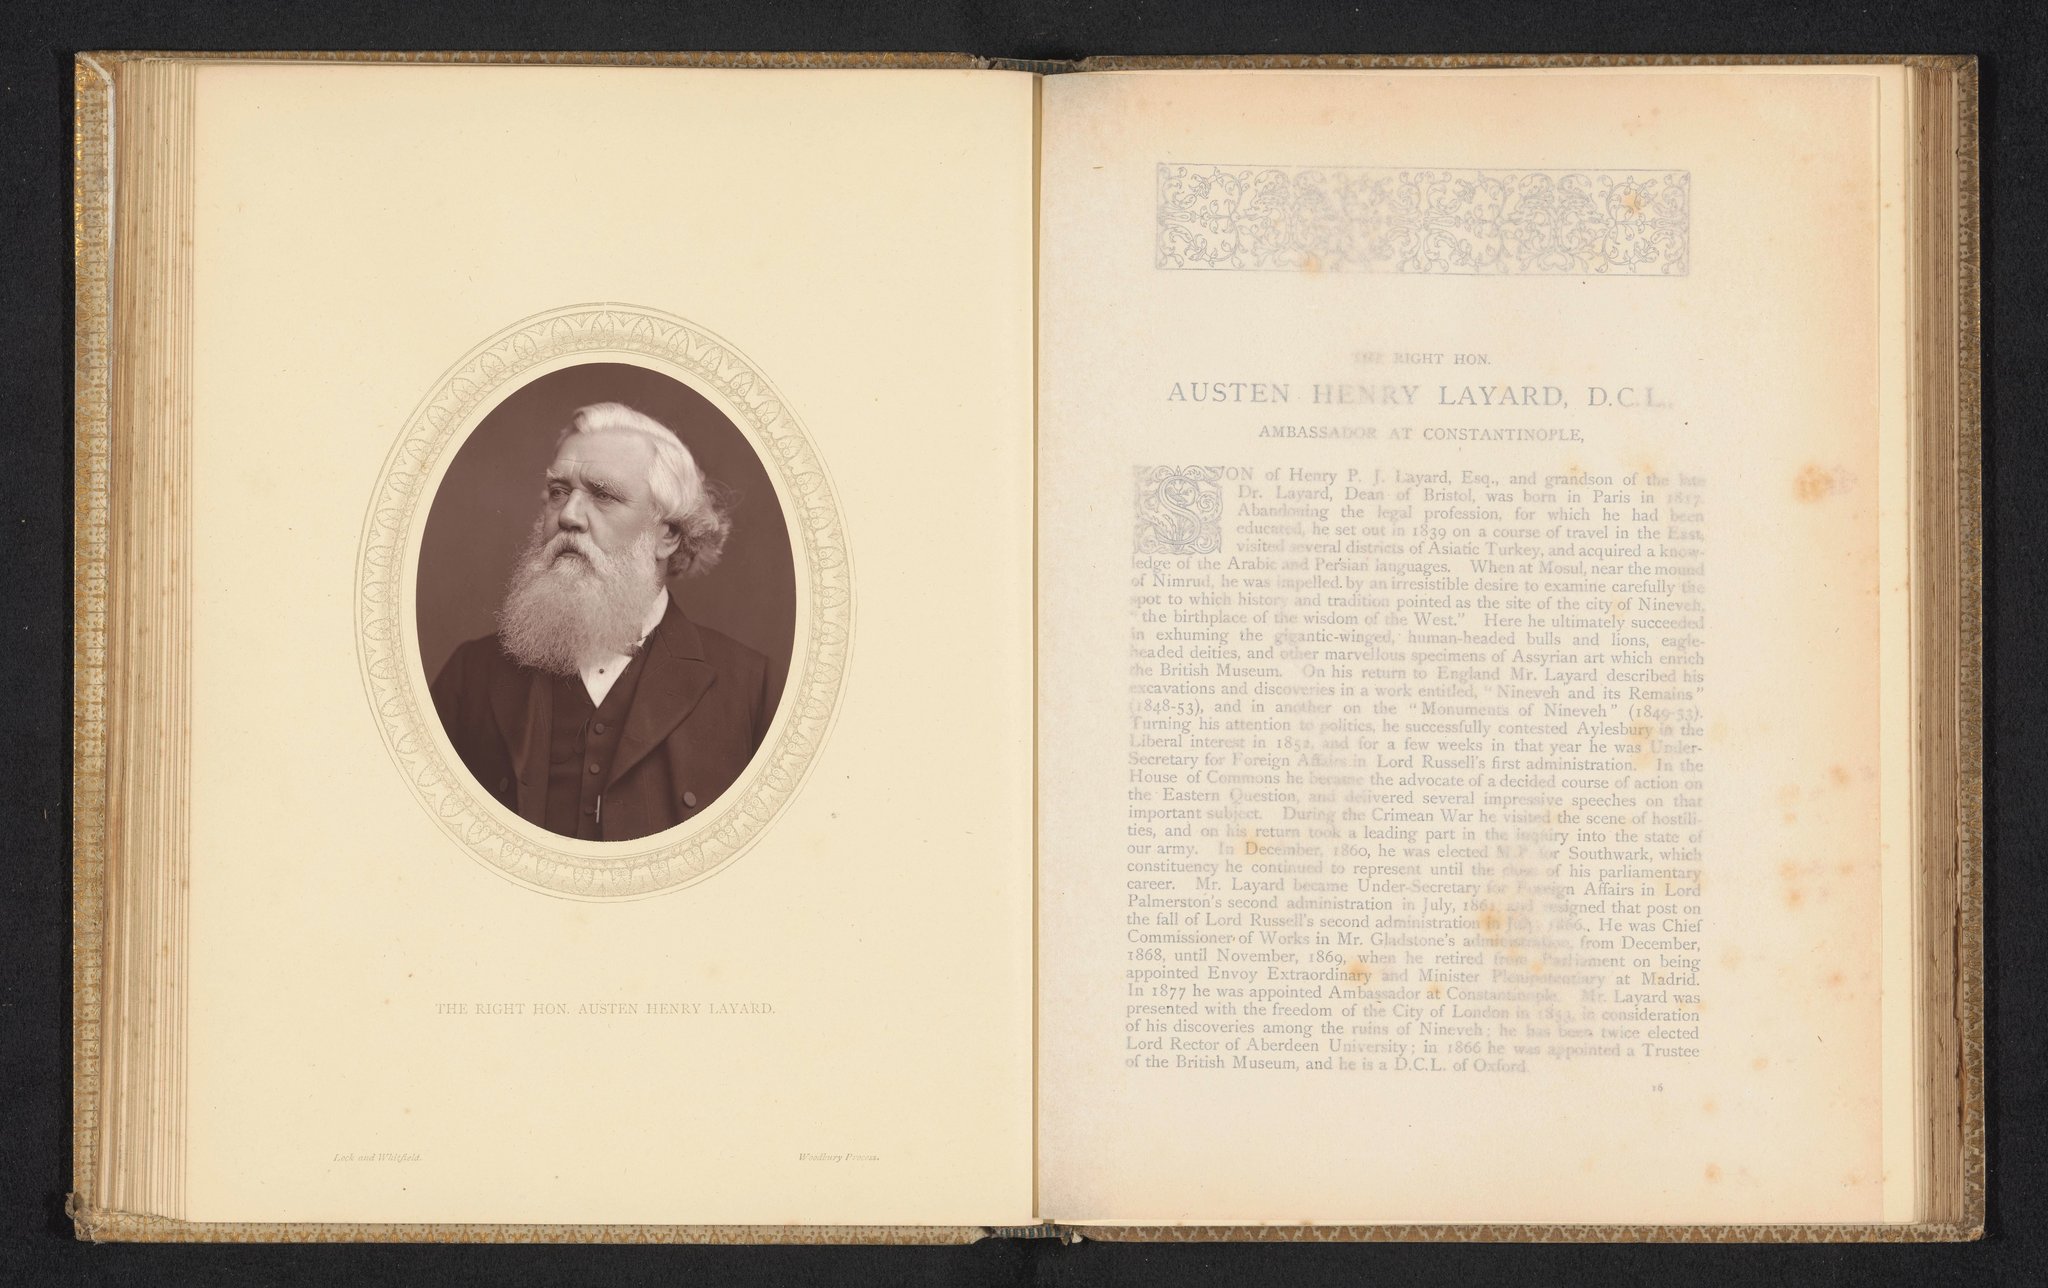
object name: page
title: The right hon. Austen Henry Layard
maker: Anonymous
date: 1871-1876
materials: paper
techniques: woodburytype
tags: historical persons (portraits and scenes from the life) (+ (full) bust portrait), writer, poet, author